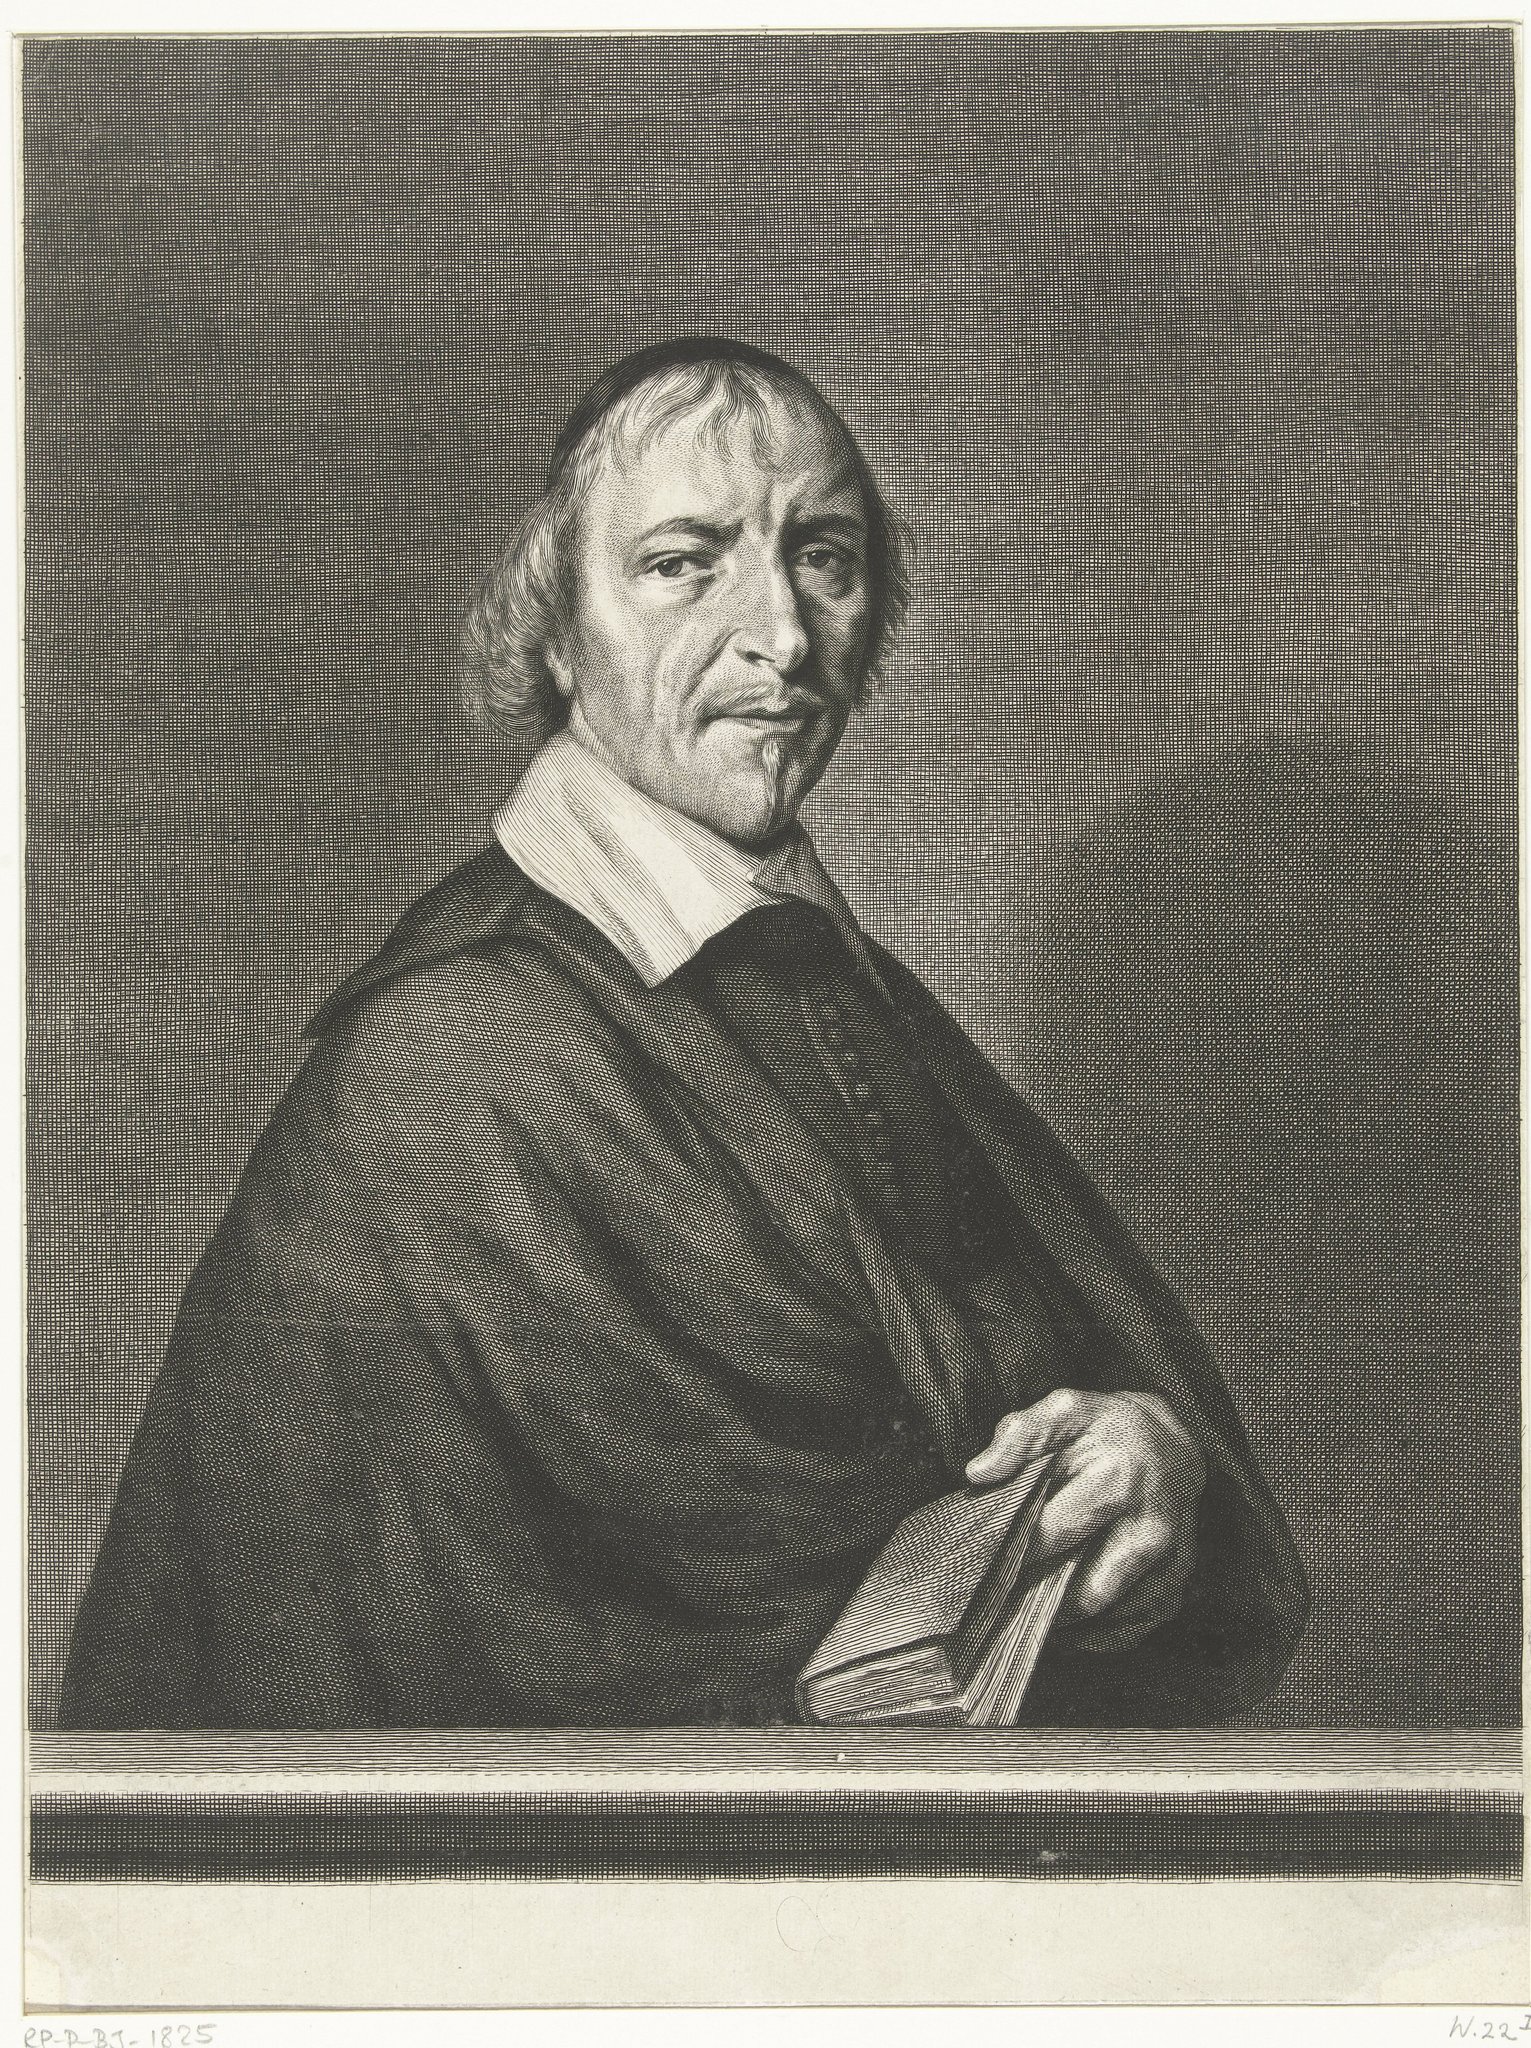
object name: print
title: Portret van Hermanus Langelius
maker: abraham bloteling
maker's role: draughtsman, print maker, publisher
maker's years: 1640-1690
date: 1655-1690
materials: paper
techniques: engraving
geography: amsterdam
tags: predikant, hermanus langelius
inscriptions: collector's mark: Lugt 2228, collector's mark: Lugt 240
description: Portret van de Amsterdamse predikant Hermanus Langelius, met een boek in zijn hand.